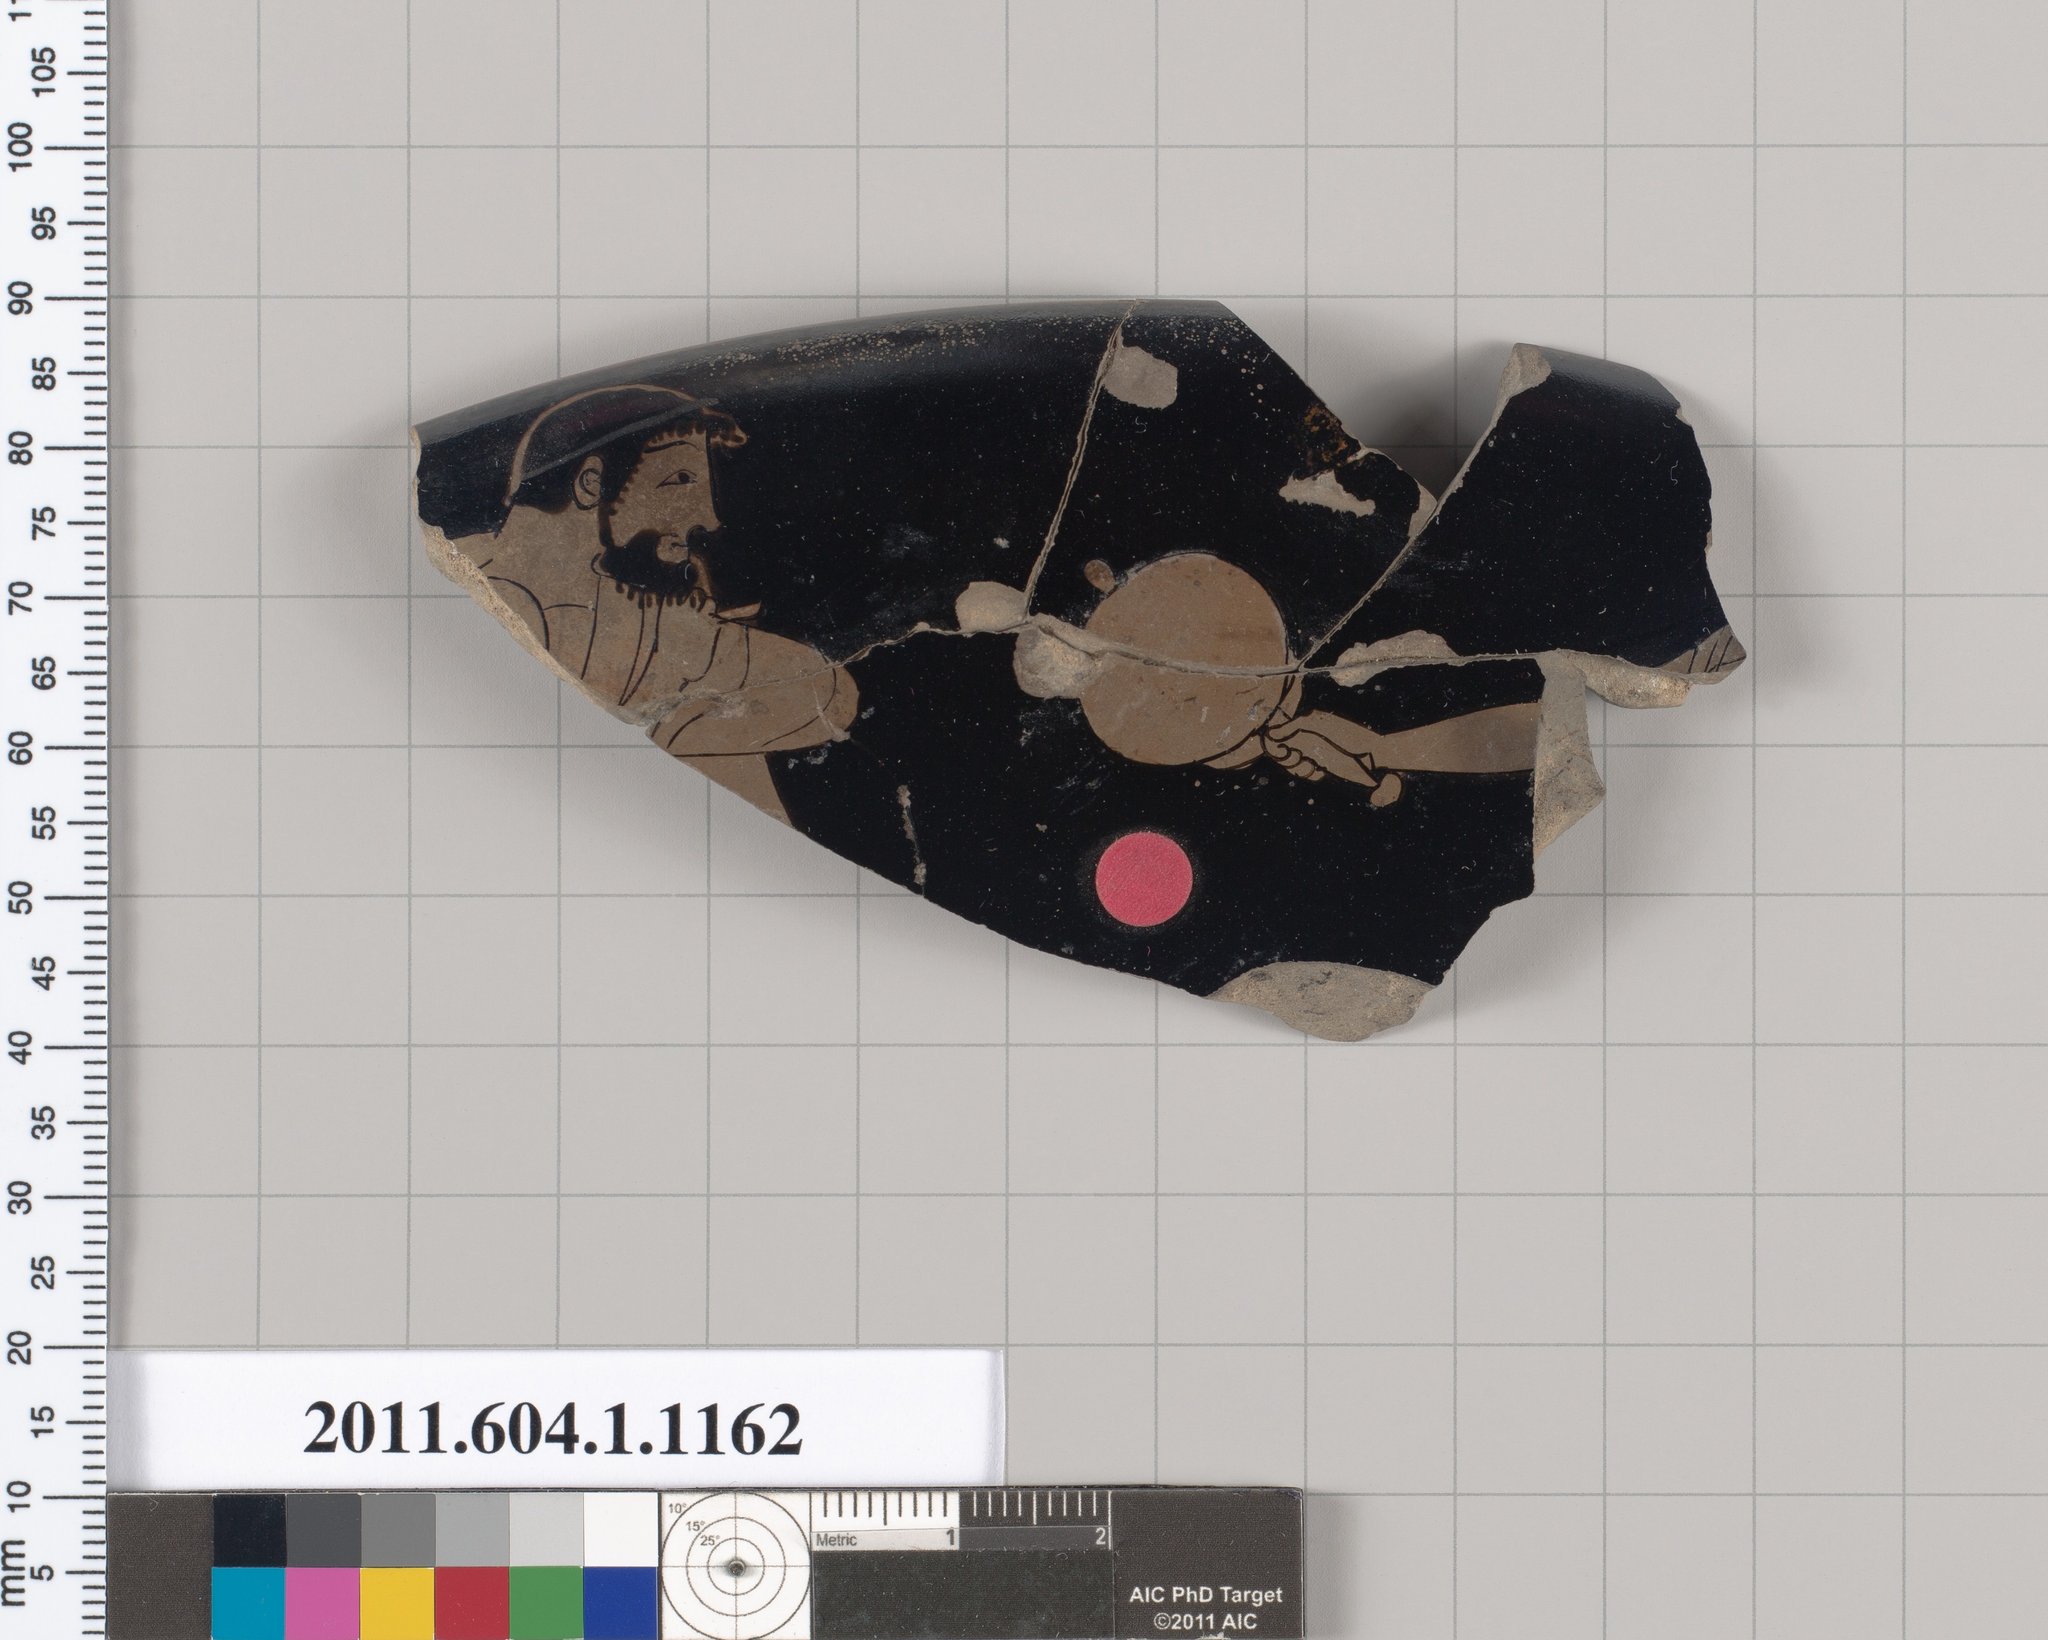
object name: kylix fragment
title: Terracotta rim fragment of a kylix (drinking cup)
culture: greek, attic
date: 490-480 BCE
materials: terracotta